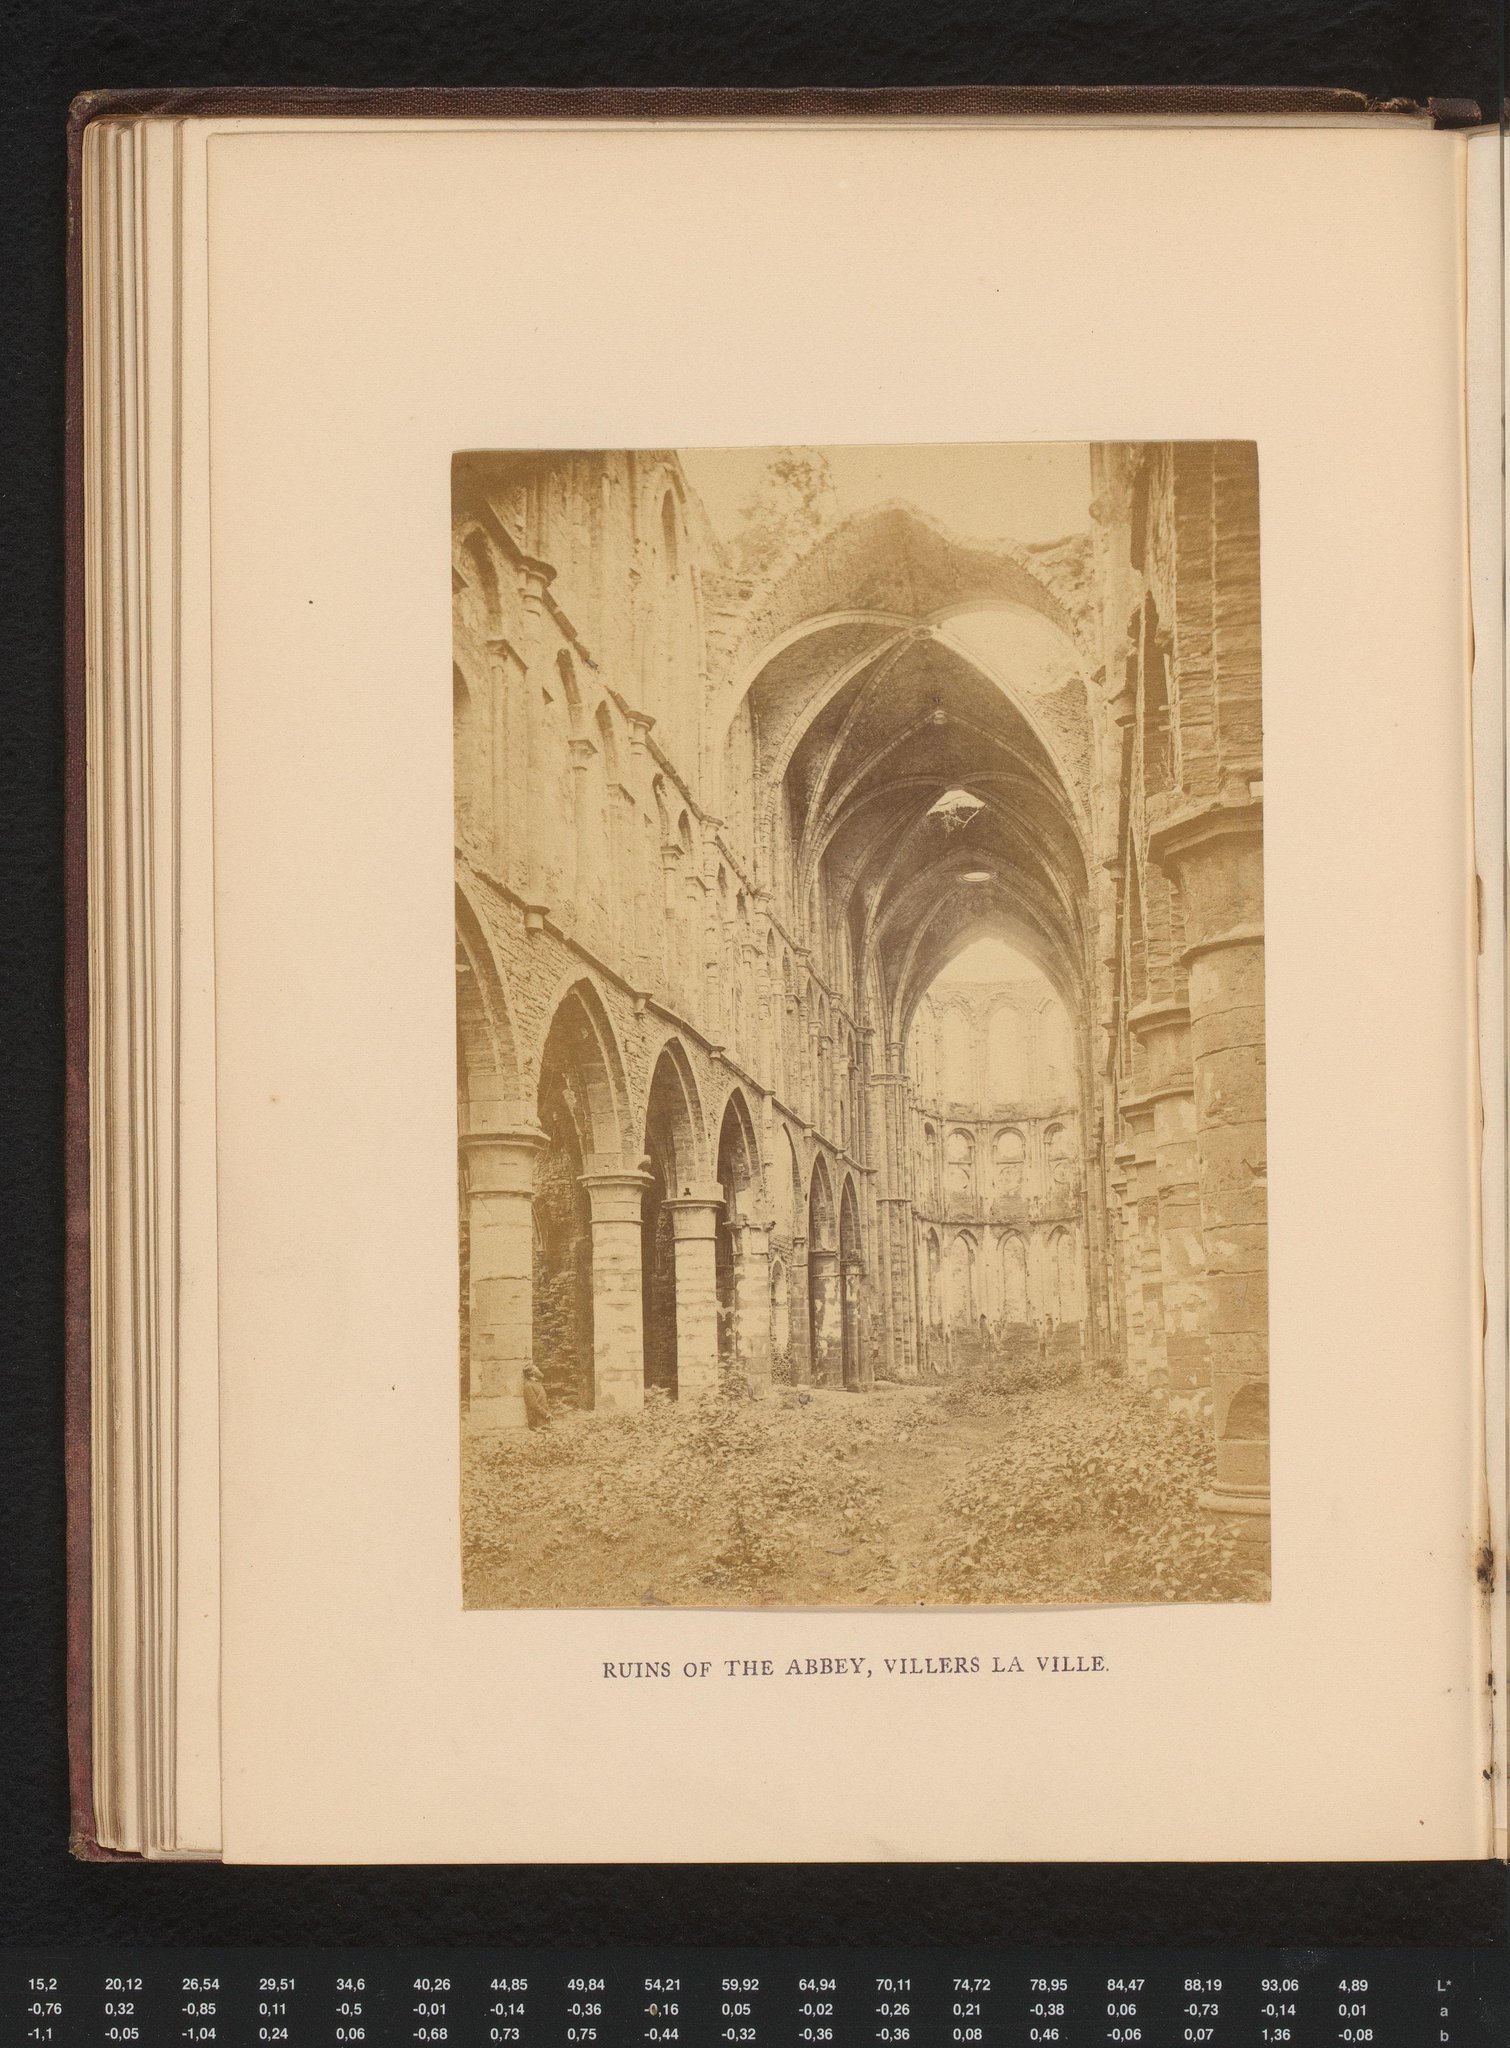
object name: page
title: Ruïne van de abdij van Villers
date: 1855-1866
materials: paper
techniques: albumen print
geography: villers-la-ville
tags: ruin of church, monastery, etc.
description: Foto op tweede ongenummerde pagina na pagina 60.